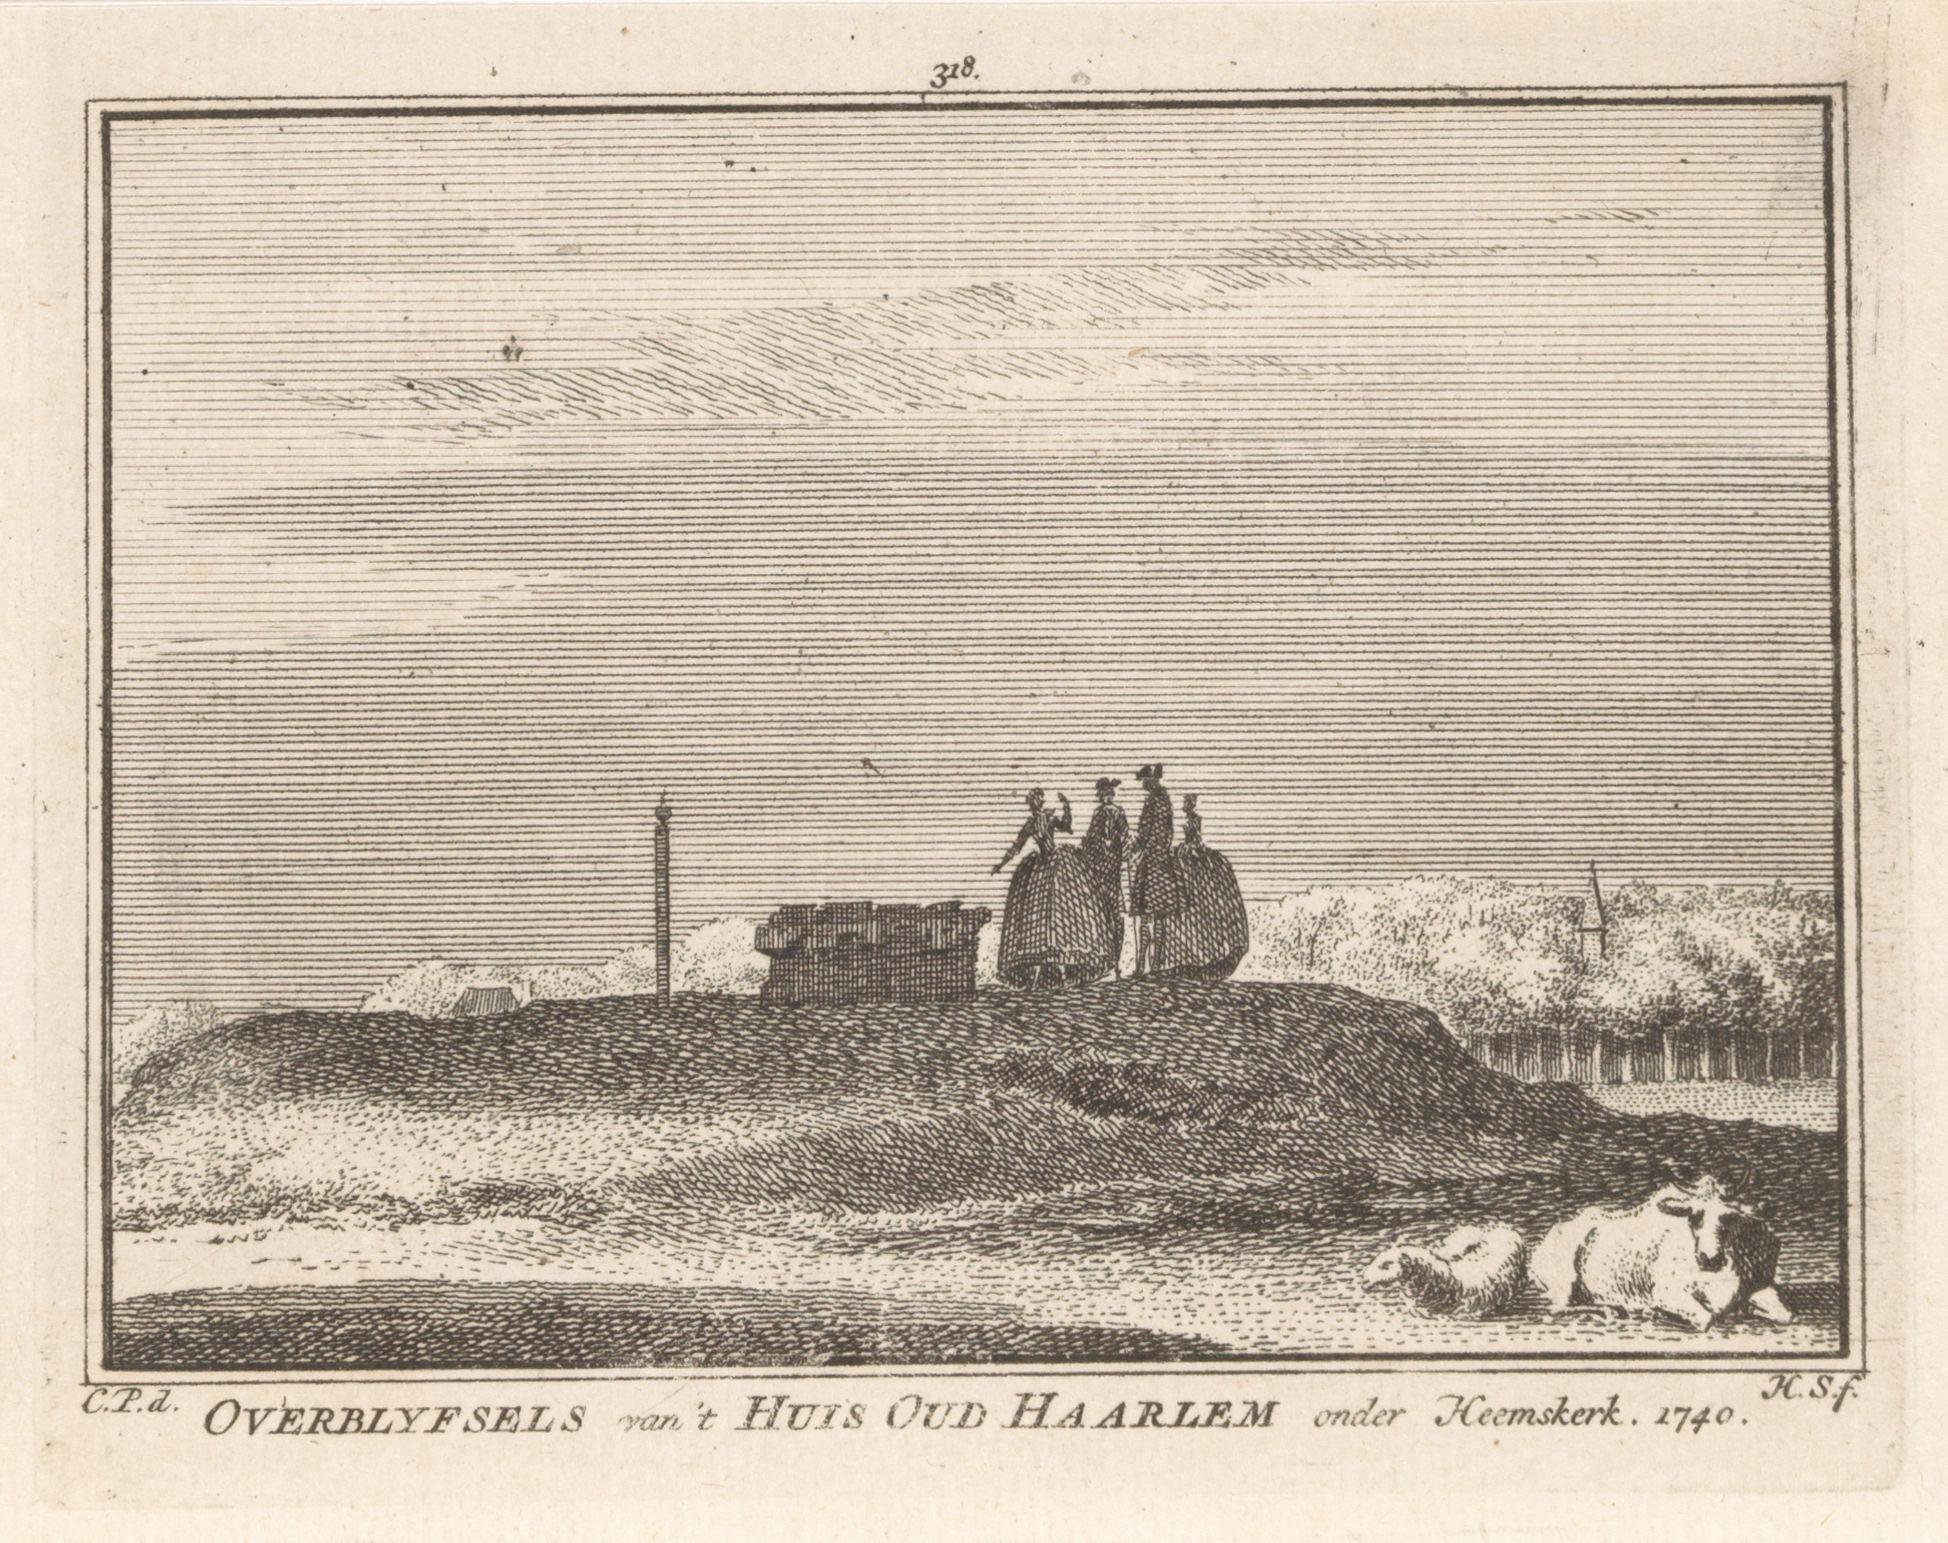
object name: book illustration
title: Overblyfsels van 't huis Oud Haarlem onder Heemskerk. 1740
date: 1752-1792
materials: paper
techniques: engraving, etching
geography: haarlem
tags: cow, ruin of a dwelling, house, castle, etc.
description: Prent ook gebruikt in: Het verheerlykt Nederland of kabinet van hedendaagsche gezigten van steden, dorpen (…). 9 delen. Amsterdam: Isaak Tirion en weduwe Isaak Tirion, 1745-1774, dl. 4 (1752), ill. 318. Of in: Nederlandsche tafereelen; of eene keurige verzameling van negen honderd fraaije gezigten van steden, dorpen, sloten, oudheden (….). 9 delen. Amsterdam: Jan de Groot, 1792, dl. 4, ill. 318. Uit welke druk het huidige exemplaar precies komt is niet na te gaan.